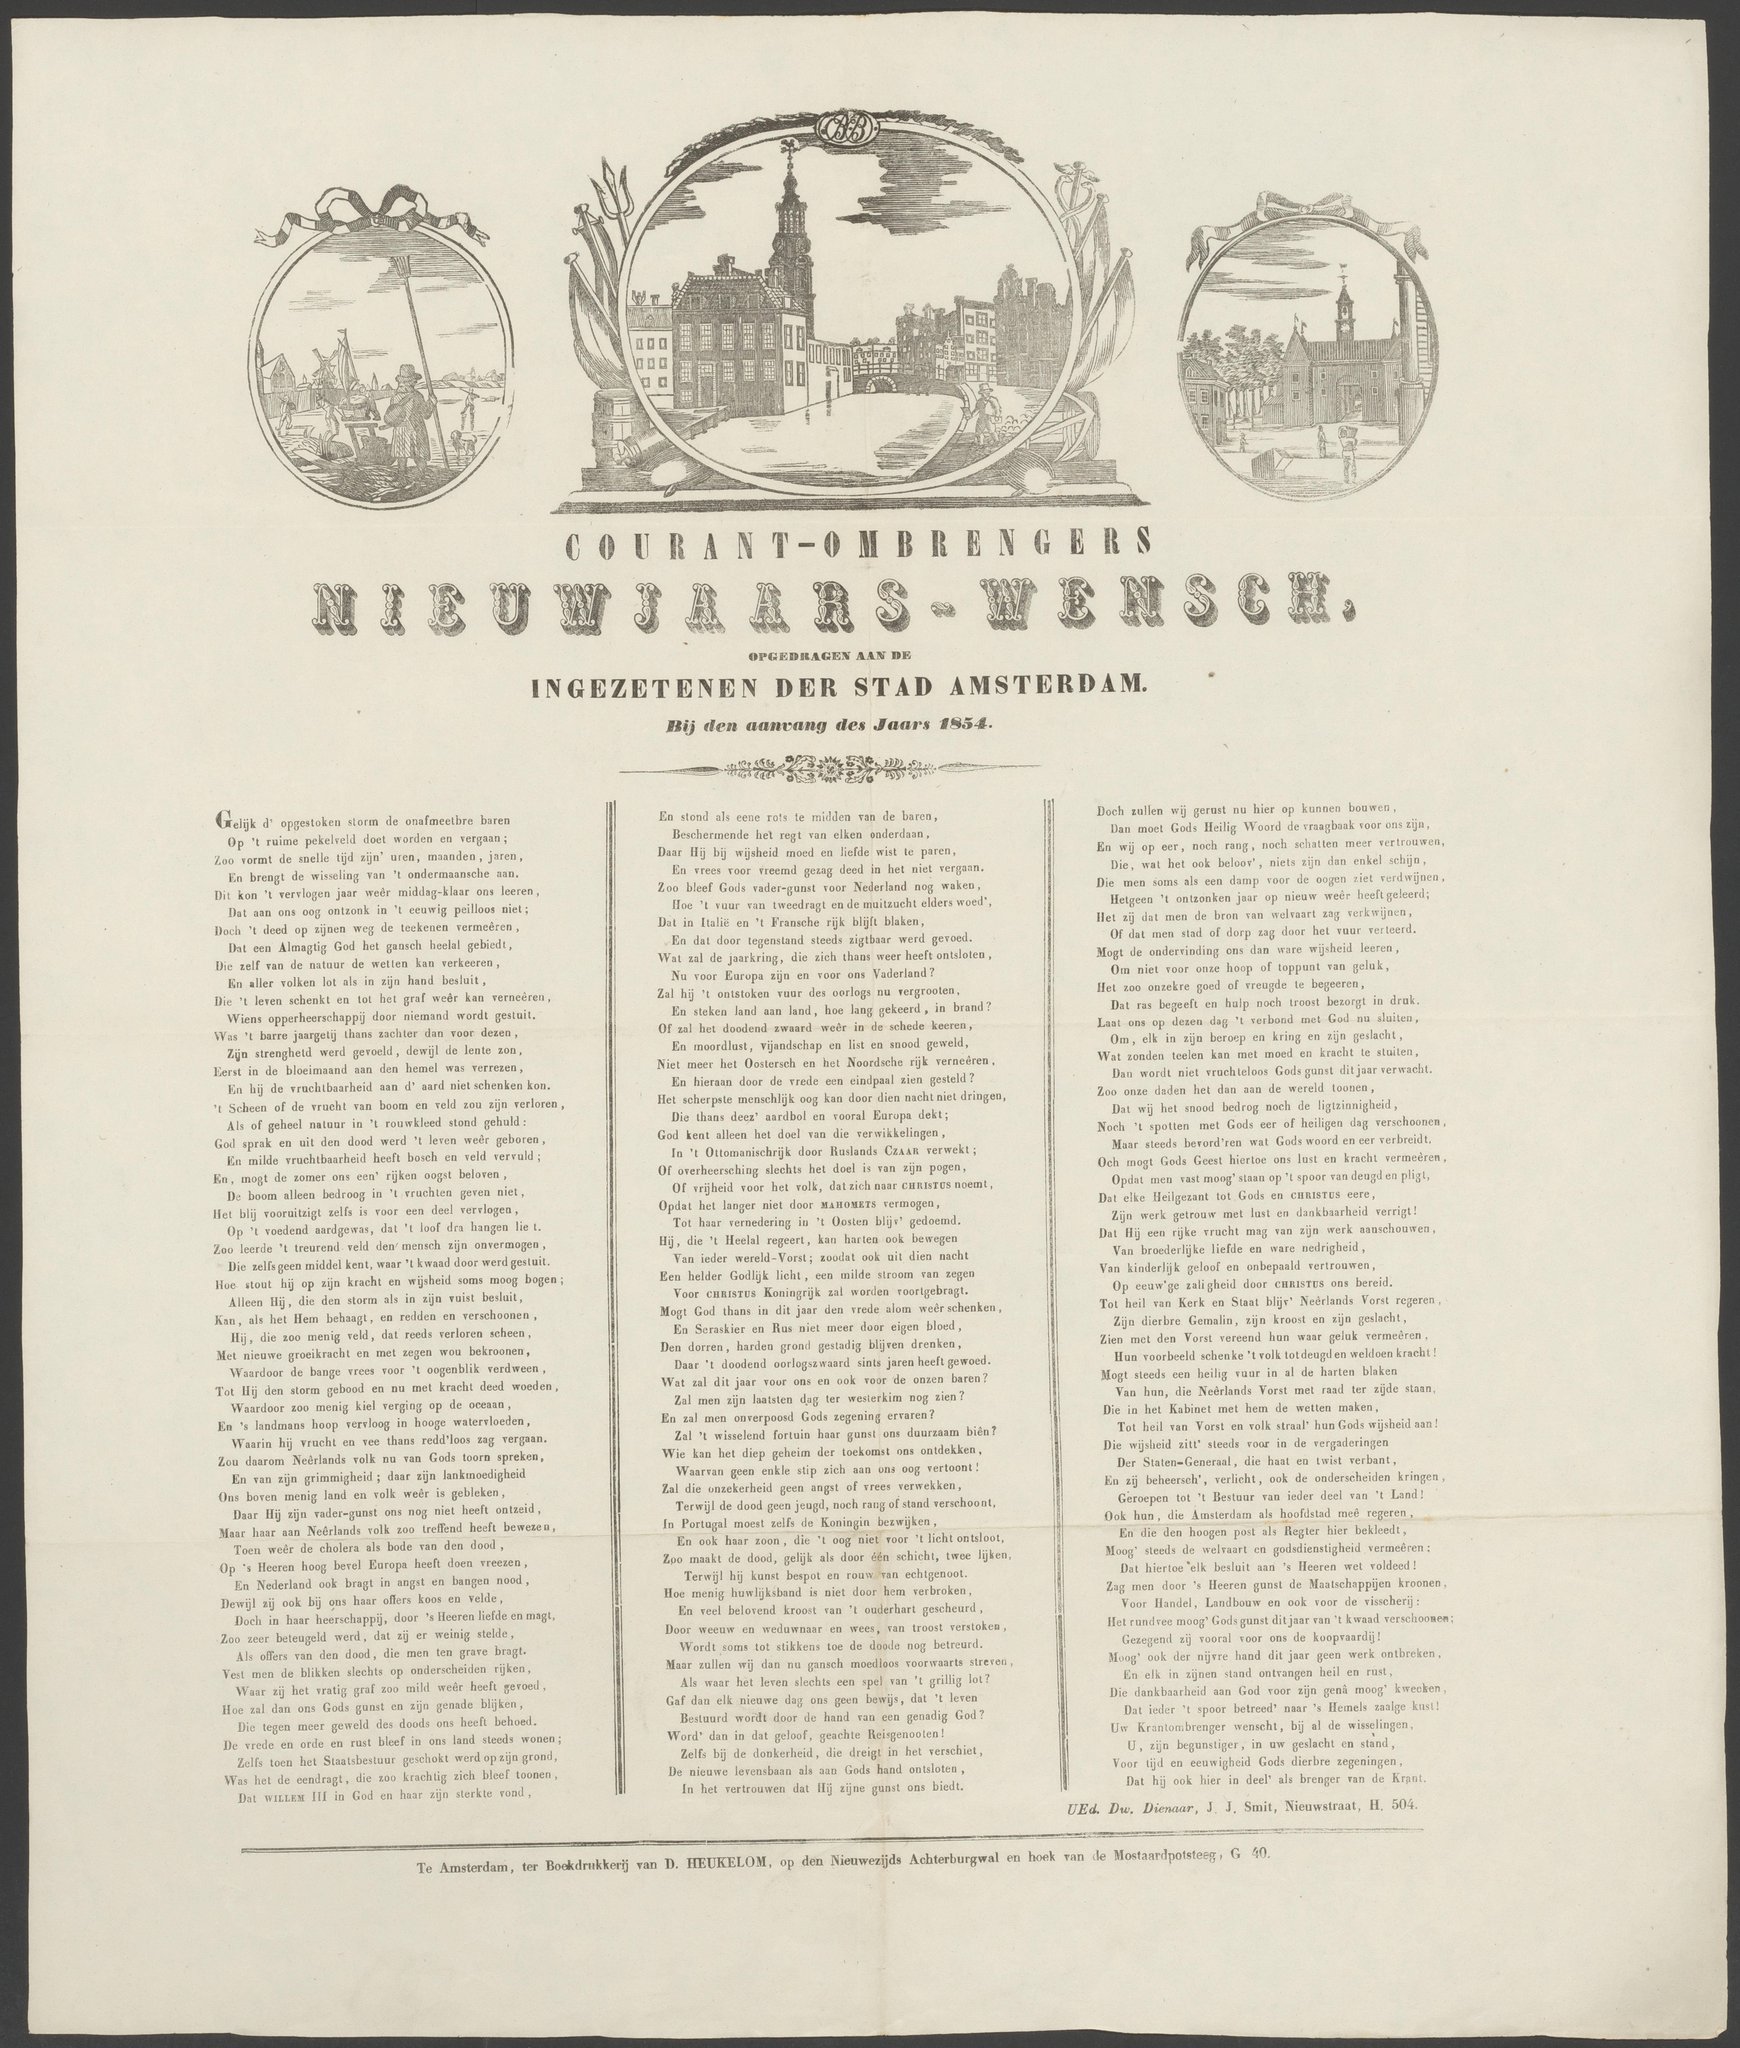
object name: print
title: Nieuwjaarwens van de courant-ombrengers van de stad Amsterdam, voor het jaar 1854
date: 1853-1854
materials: paper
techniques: letterpress printing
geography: amsterdam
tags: delivery (of newspaper), street, amsterdam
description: Nieuwjaarswens namens de ombrengers van couranten (krantenbezorgers) te Amsterdam voor het jaar 1854. Bovenaan drie medaillons met centraal een gezicht op het Singel bij de Munt met op de kade een krantenbezorger, links ijsvermaak buiten de stadswal, rechts de Leidsepoort. Onderaan een gedicht in drie kolommen. Van de courantombrenger: J.J. Smit. Onderwerpsrubrieken binnen de Atlas Zeden en Gewoonten: Zeden en gewoonten in engeren zin, Volksleven, Volksbladen, Nieuwjaars- en Kerstwenschen, Amsterdam.